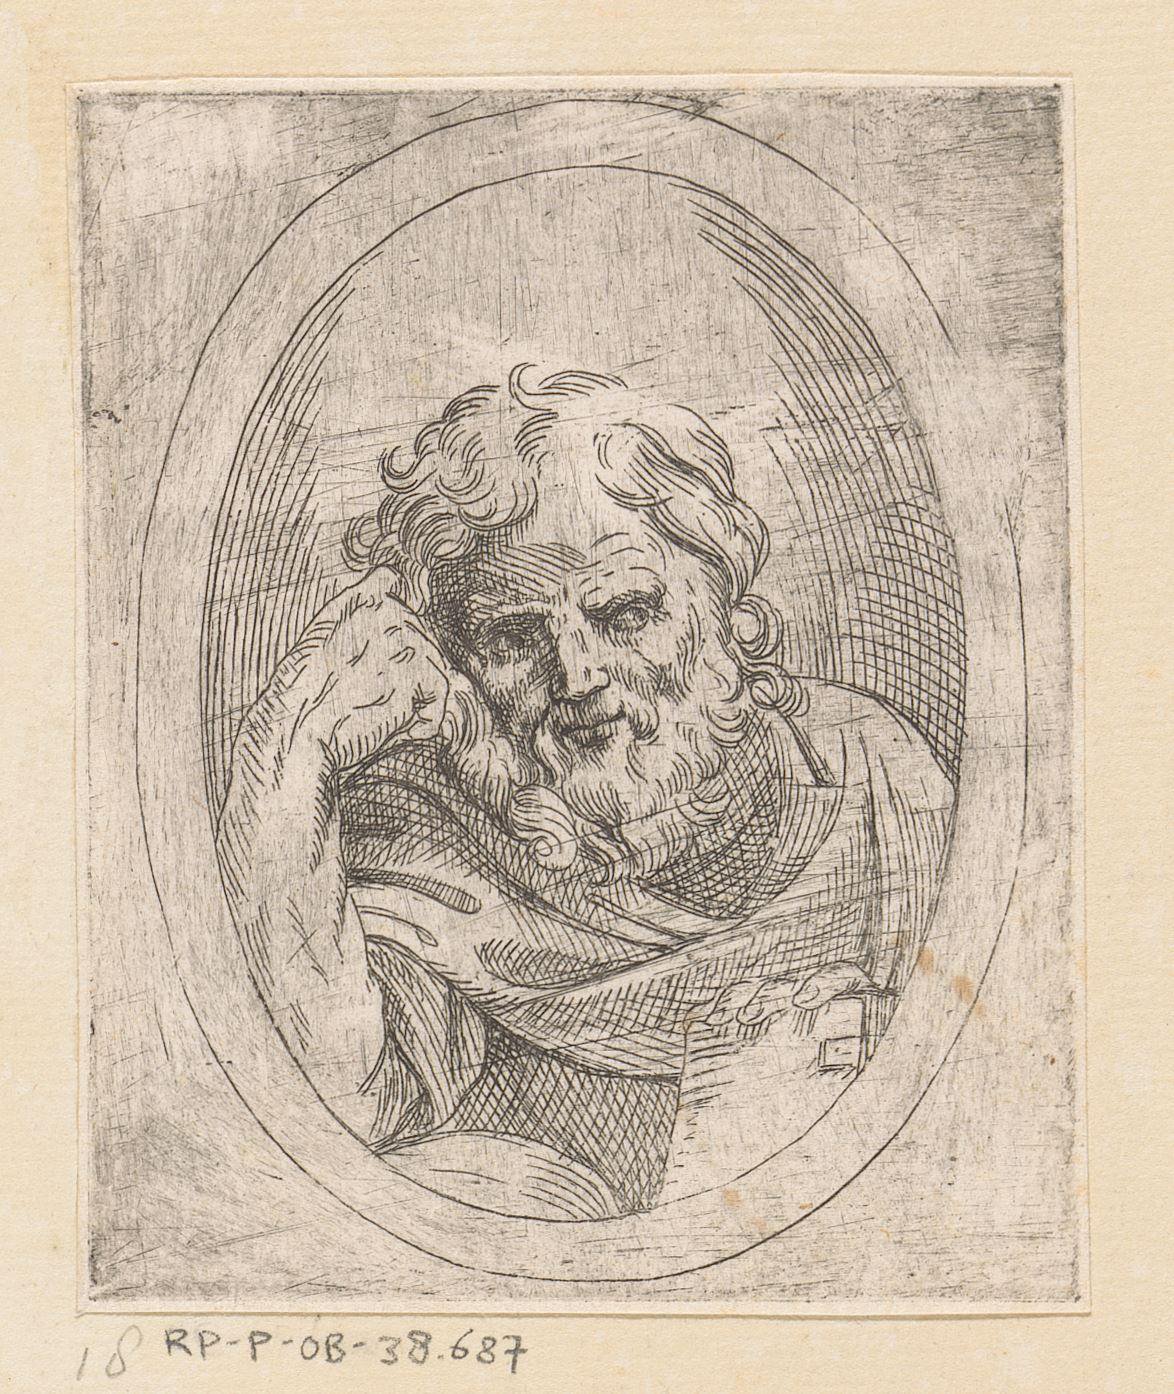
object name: print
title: Apostel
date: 1595-1692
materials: paper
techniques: etching, intaglio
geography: italy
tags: (single) apostle, unspecified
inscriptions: collector's mark: Lugt 240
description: Deze prent maakt deel uit van een serie van vijftien prenten met beeltenissen van Christus, Maria en apostelen, gevat in ovalen.